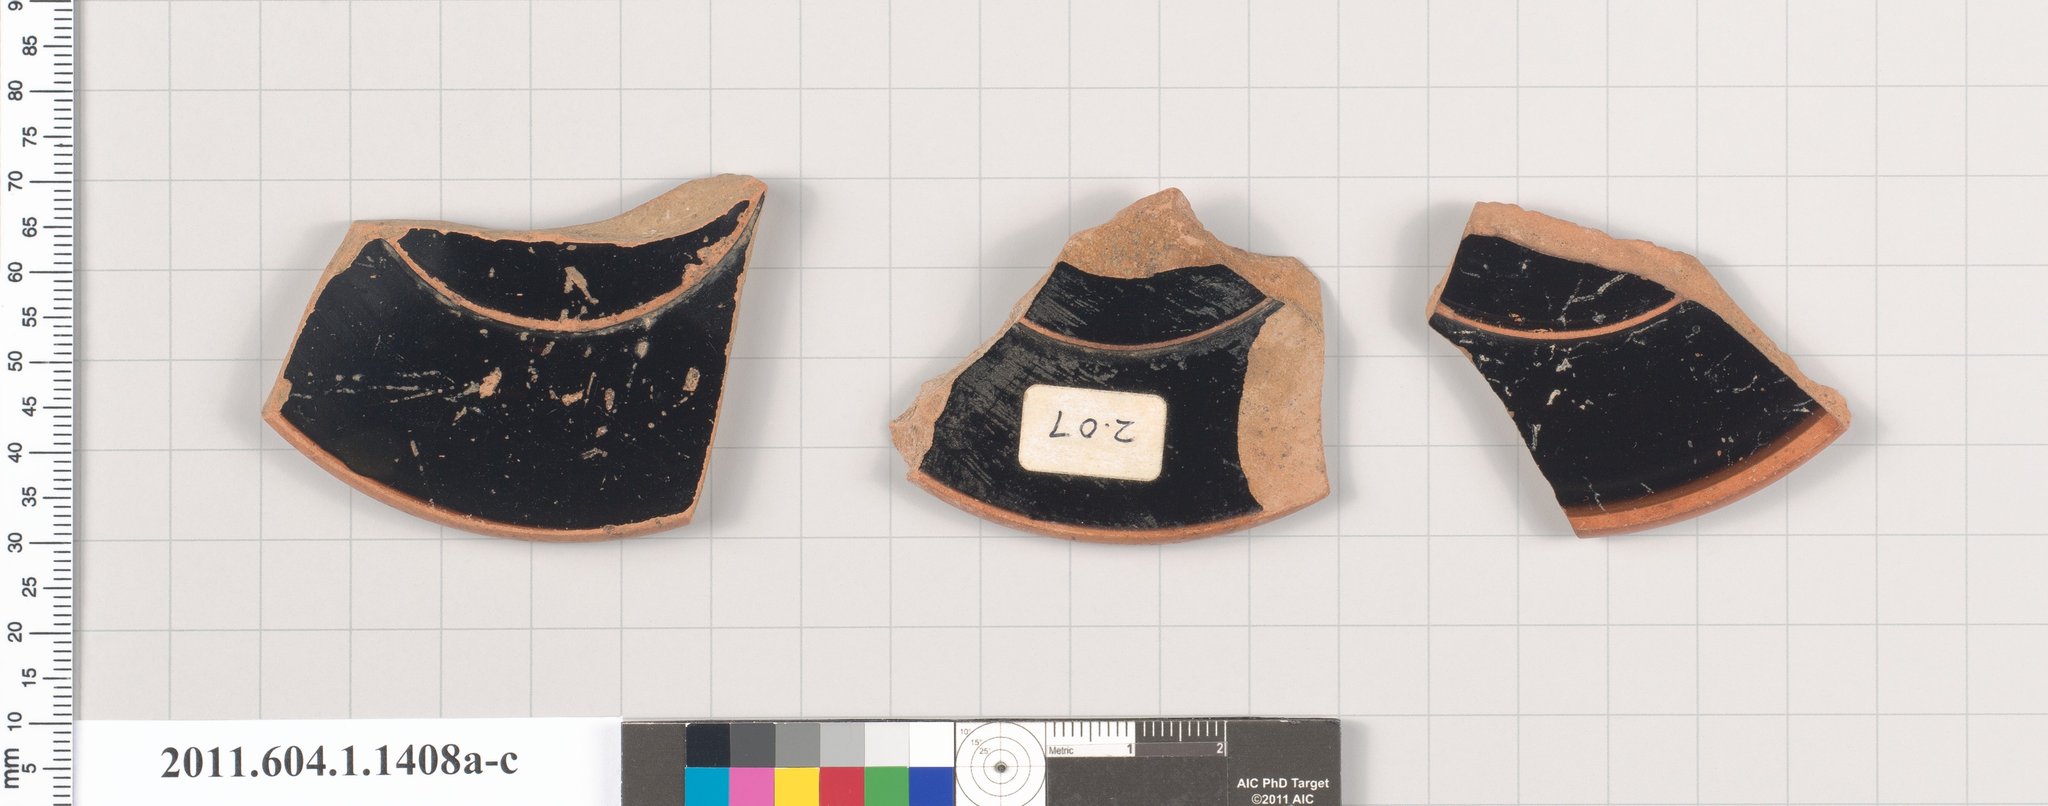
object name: kylix fragment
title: Terracotta fragments of kylikes (drinking cups)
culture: greek, attic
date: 500-401 BCE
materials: terracotta